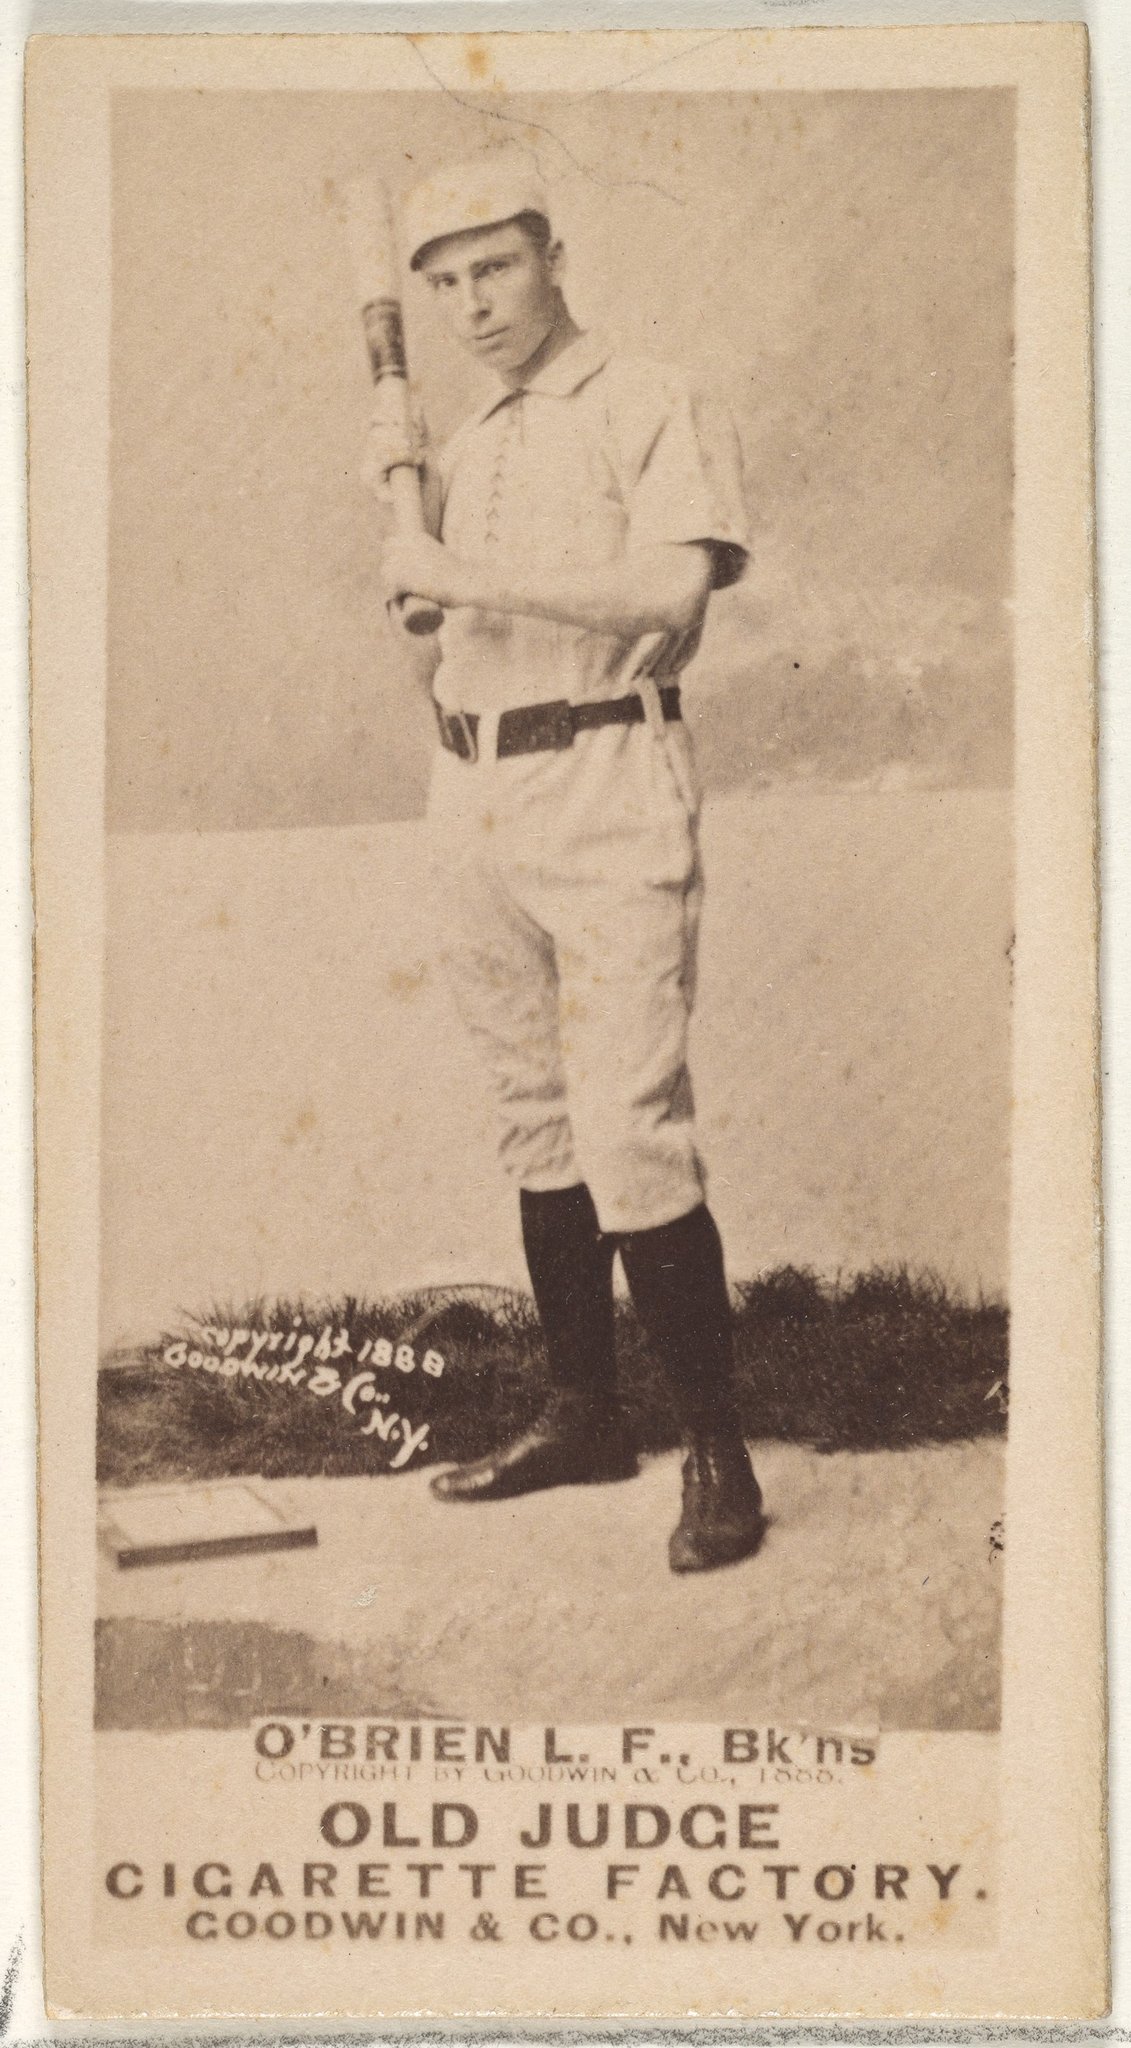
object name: baseball card, photograph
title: Darby O'Brien, Left Field, Brooklyn Bridegrooms, from the Old Judge series (N172) for Old Judge Cigarettes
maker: goodwin & company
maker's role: publisher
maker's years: 1850-1950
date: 1888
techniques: albumen silver print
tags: men,portraits,baseball,athletes